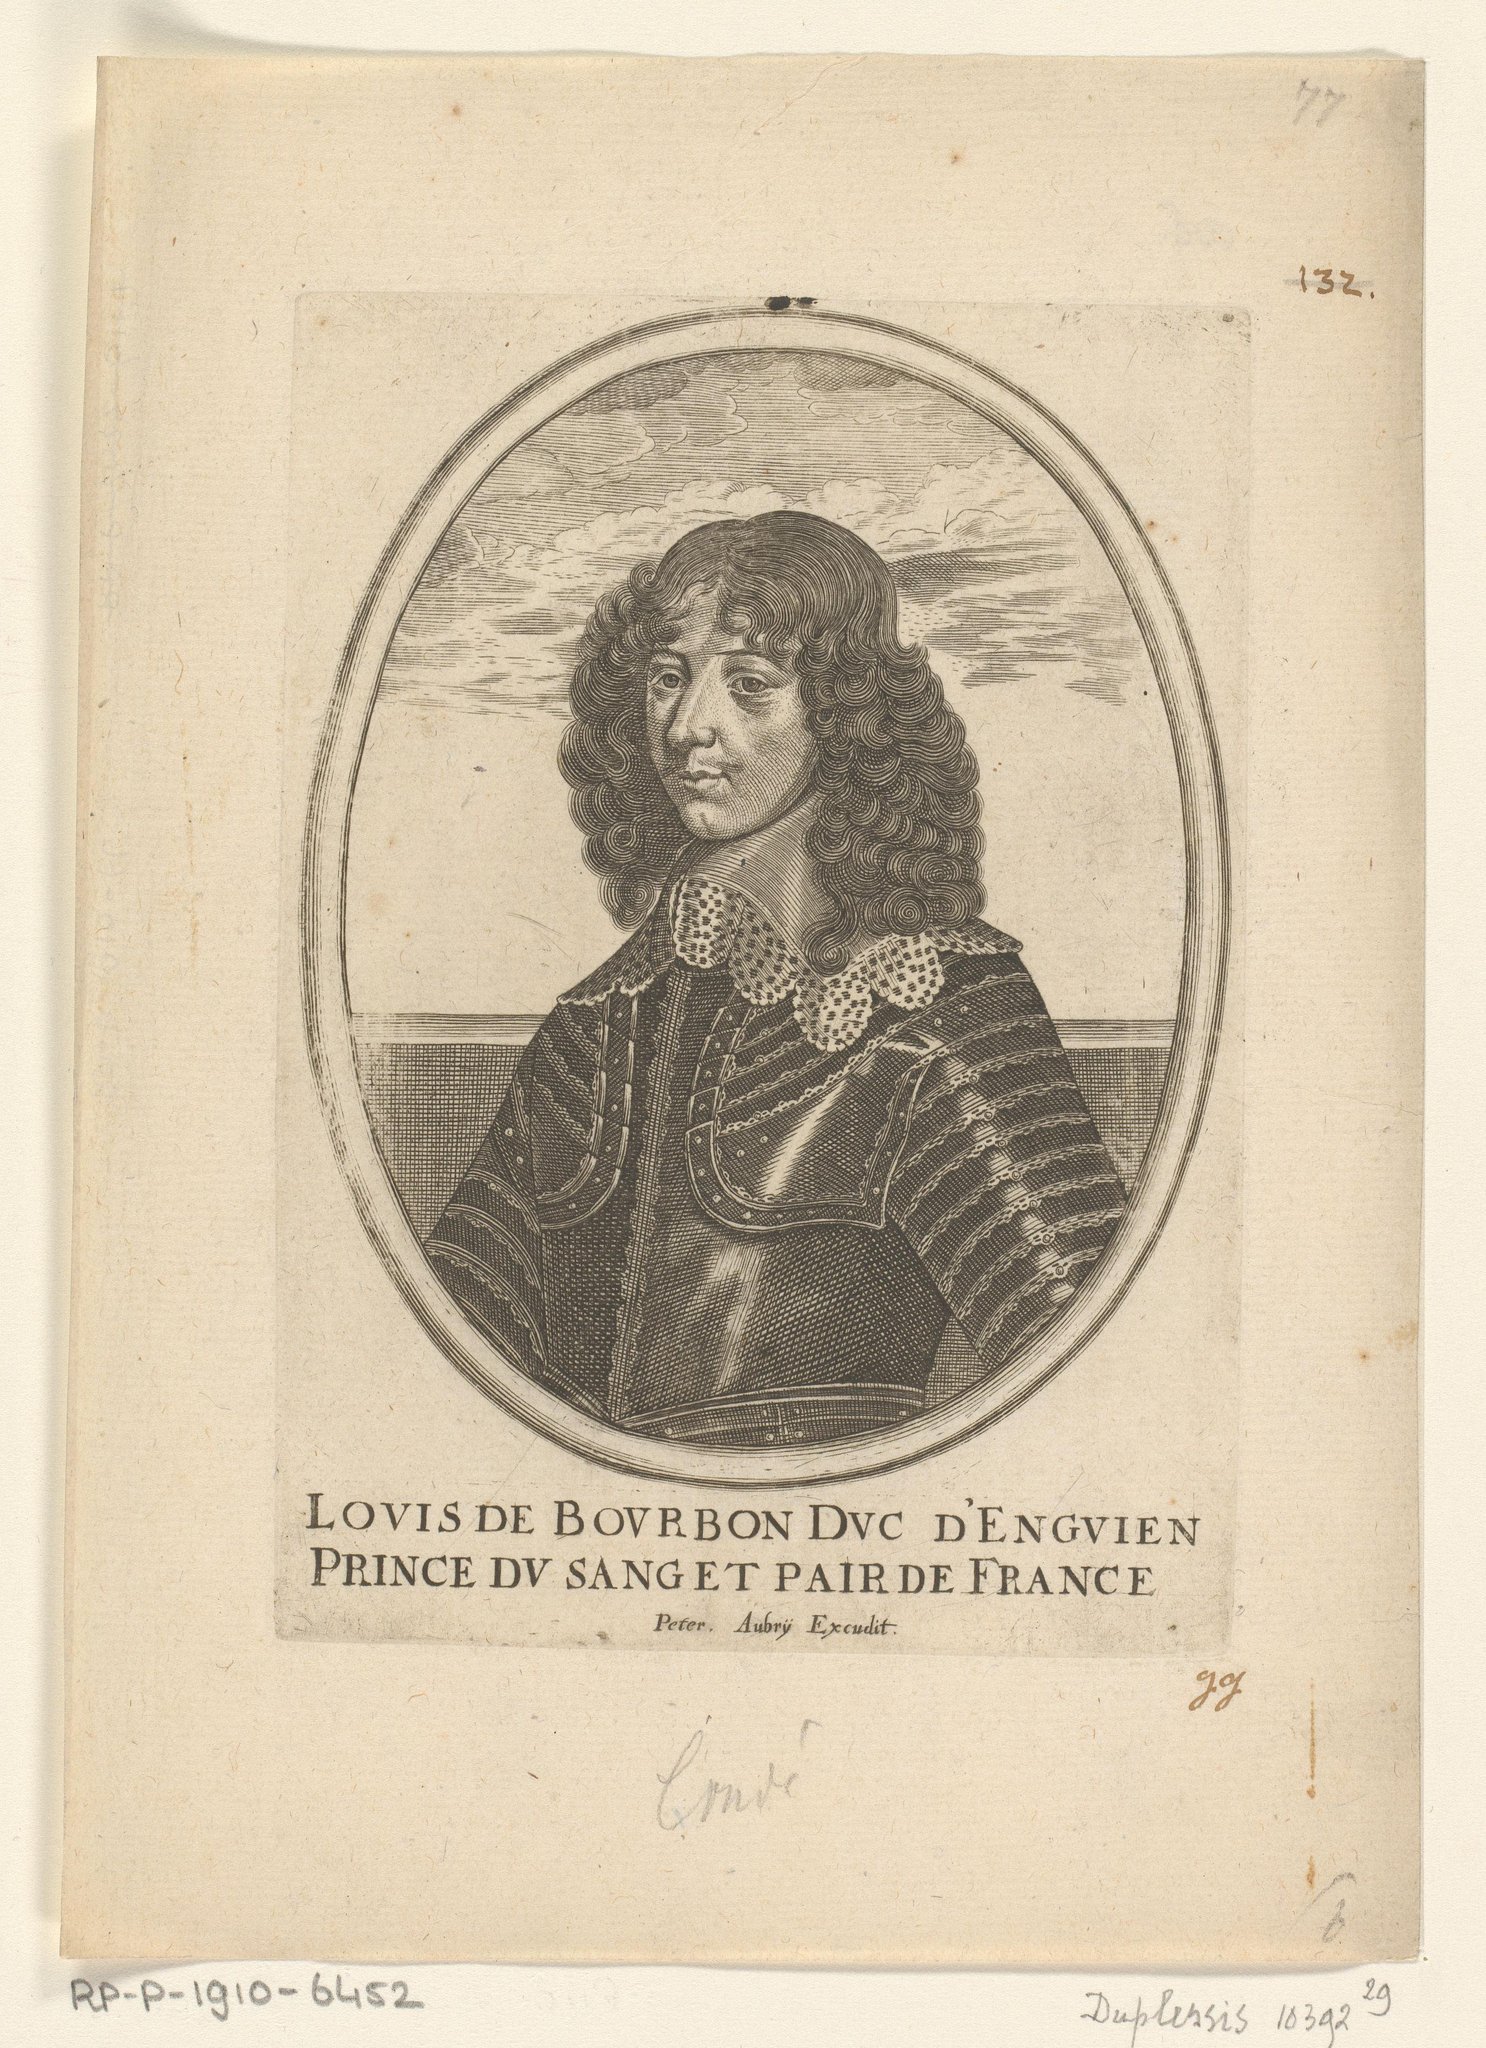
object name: print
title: Portret van Lodewijk II de Bourbon-Condé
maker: Anonymous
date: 1636-1686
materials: paper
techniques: engraving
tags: lodewijk ii de bourbon-condé (hertog van enghien), prince, historical persons, other sovereign (with title)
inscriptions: collector's mark: Lugt 2228, number: ‘132’, inscription: ‘gg’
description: Met tweeregelig onderschrift in het Frans.